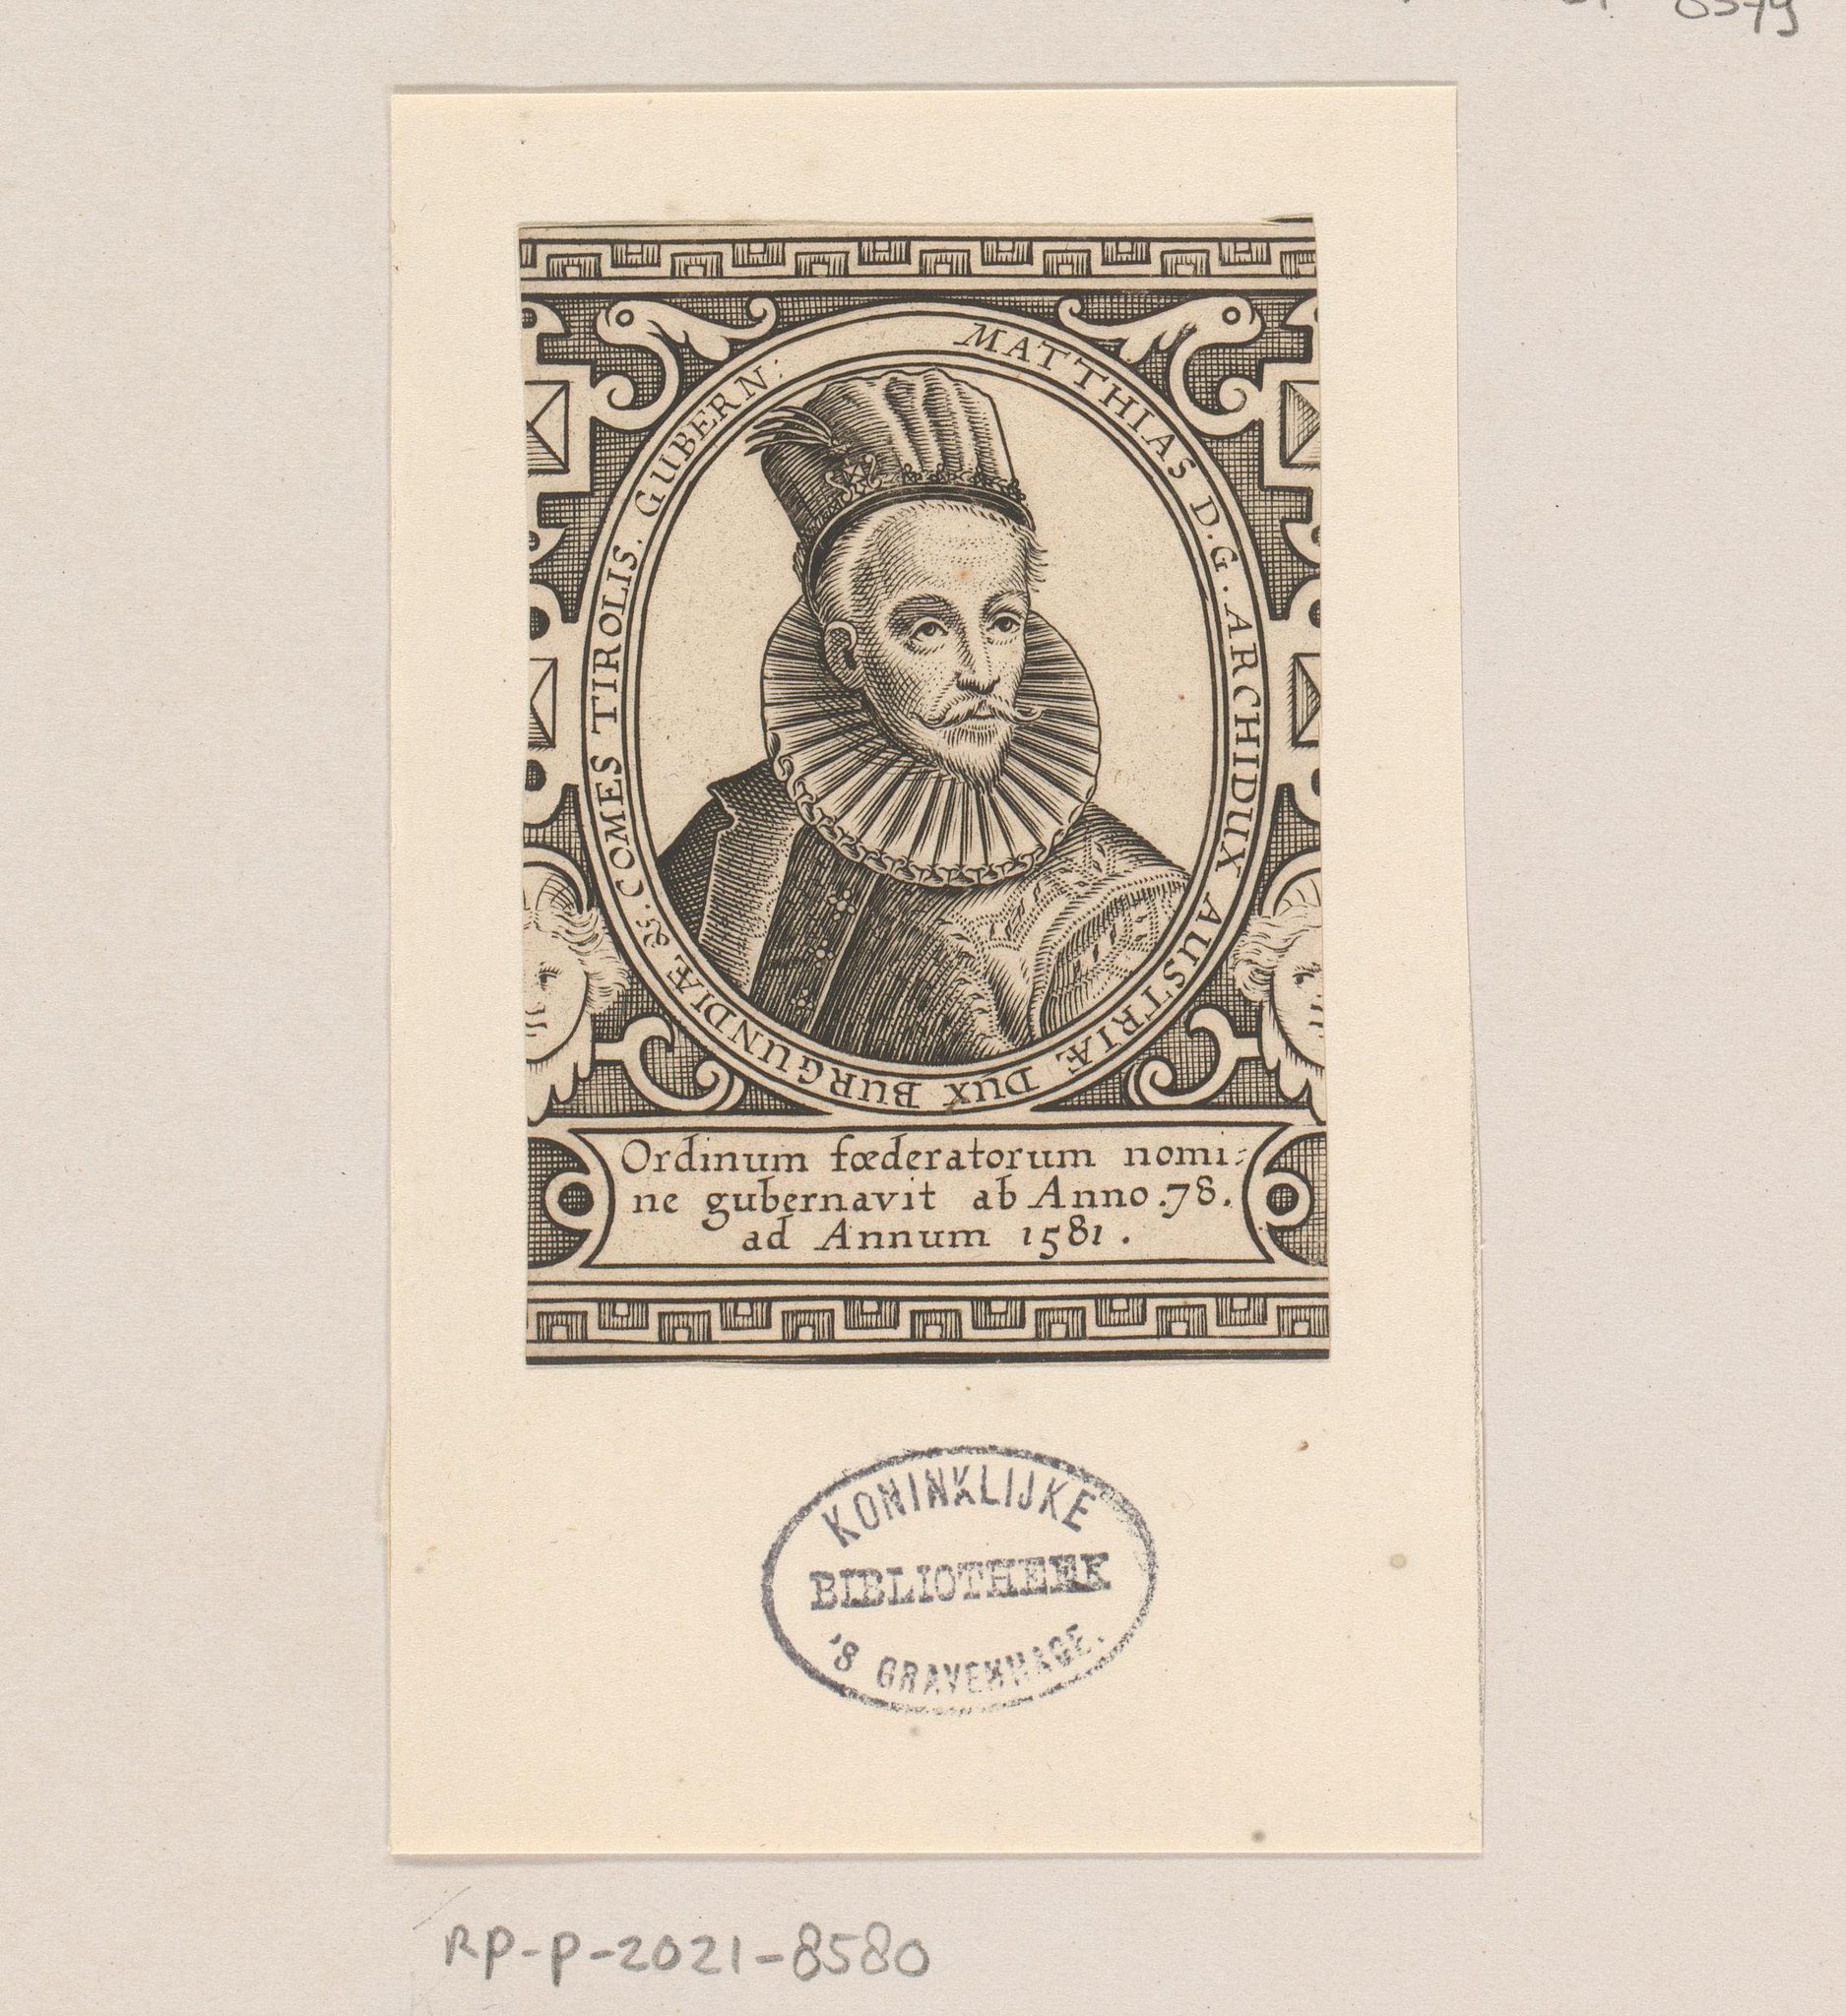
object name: print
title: Portret van keizer Matthias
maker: Anonymous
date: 1581-1620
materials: paper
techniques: engraving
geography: low countries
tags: vienna, matthias van oostenrijk (rooms-duits keizer), historical persons, emperor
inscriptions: collector's mark: Lugt 1097